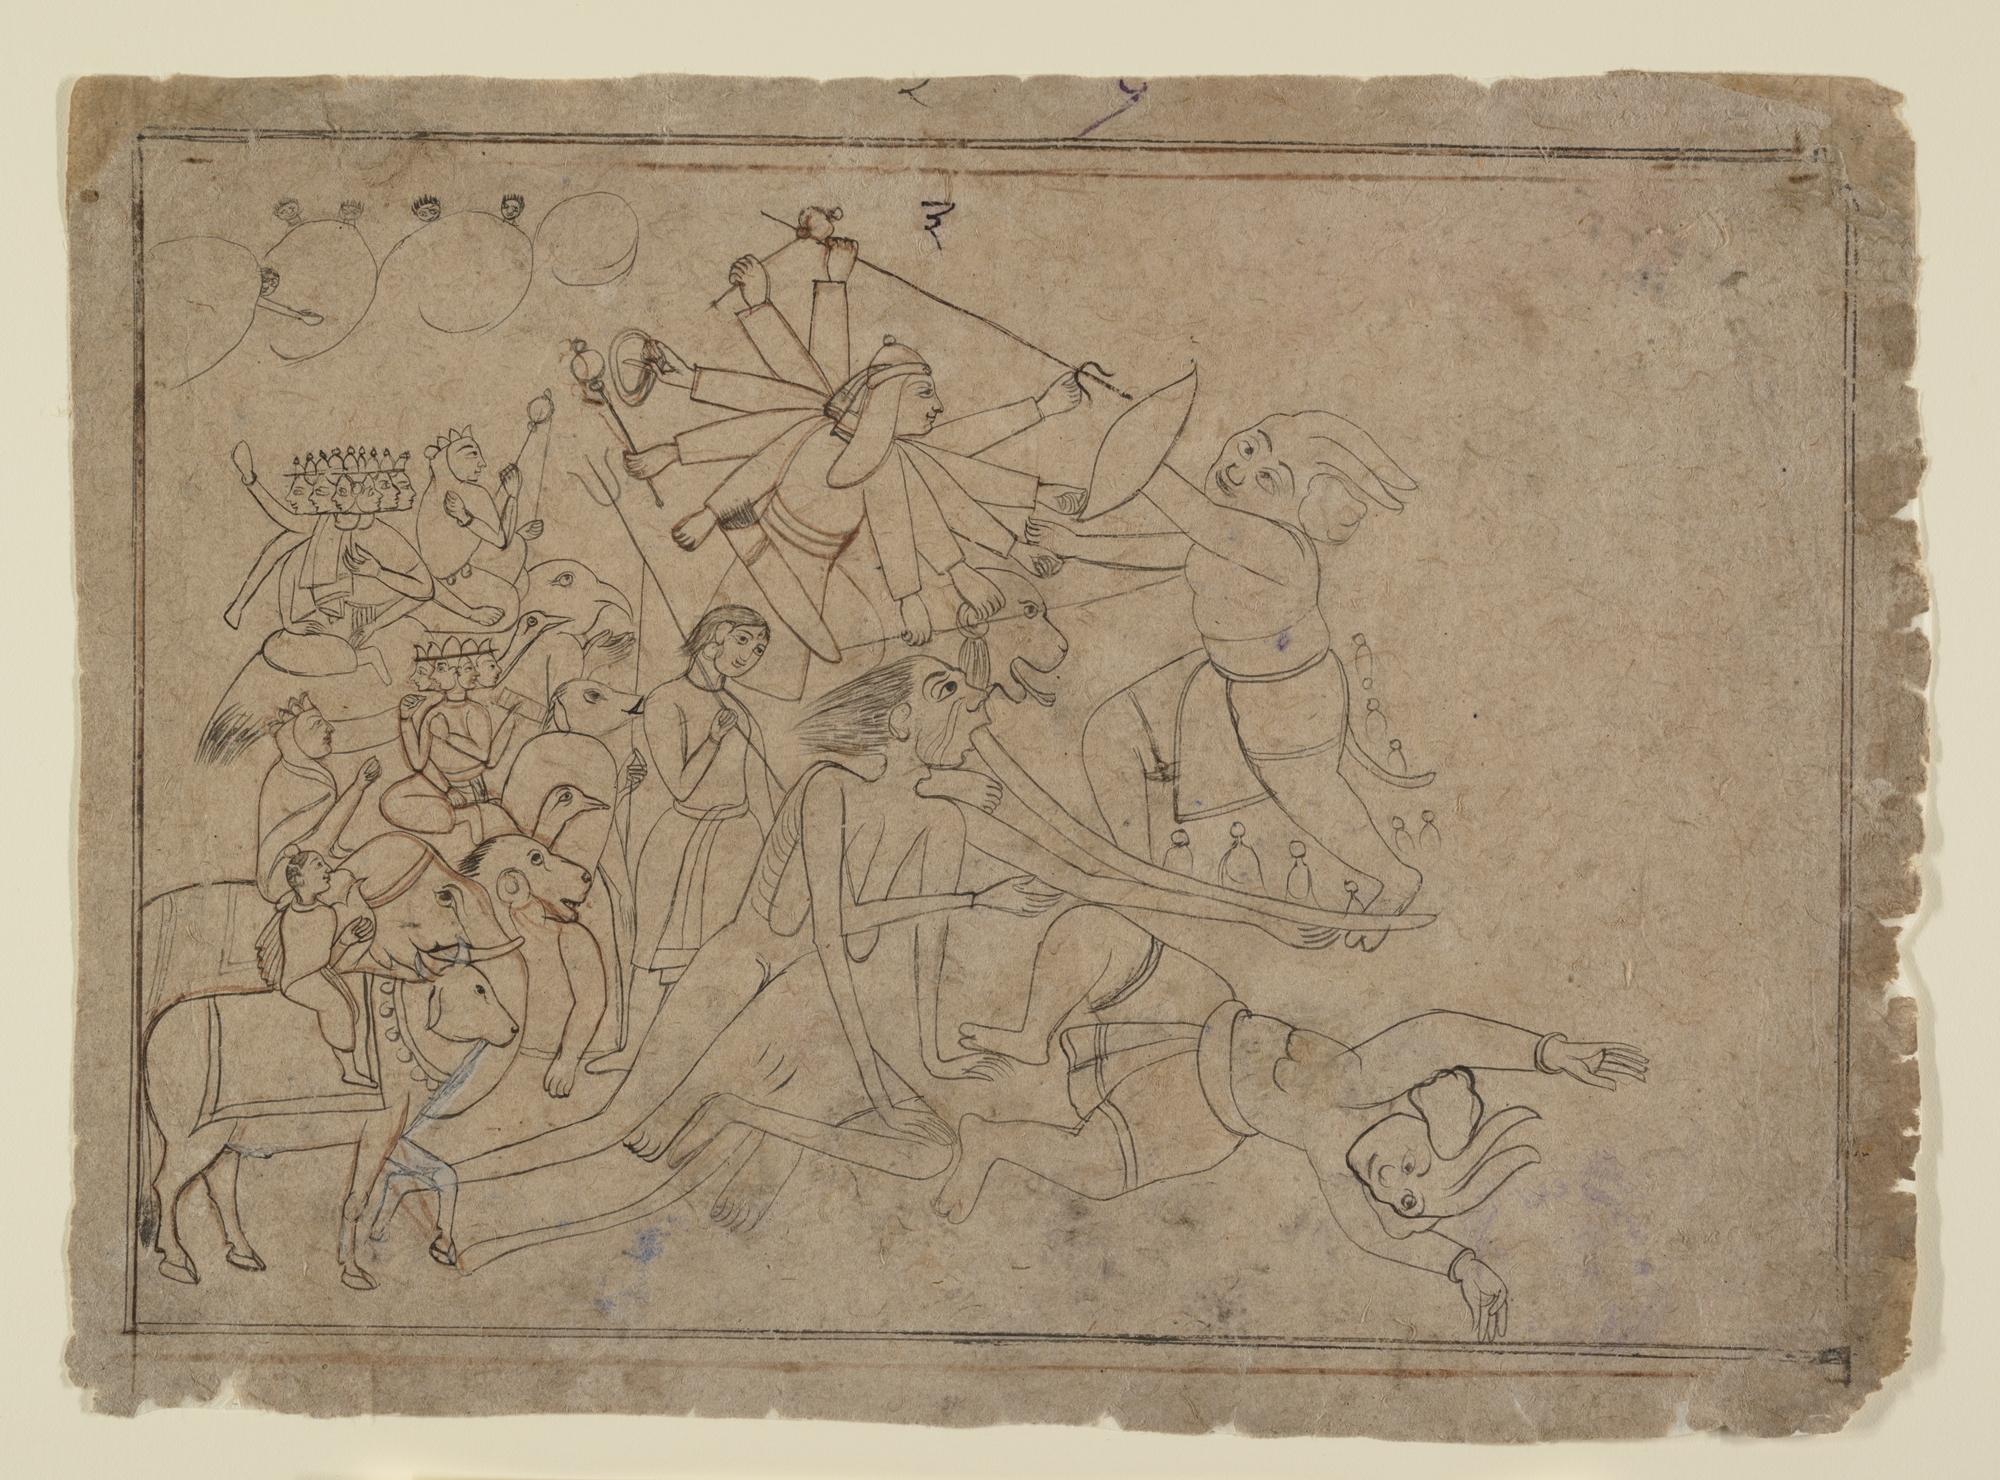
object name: painting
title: Durga, Kali, and the Matrikas Battle the Demon Raktabija: Scene from the Devi Mahatmya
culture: indian, guler, himachal pradesh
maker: nainsukh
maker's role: artist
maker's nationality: indian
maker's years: 1725-1778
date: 1780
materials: ink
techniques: drawing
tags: battles,elephants,demons,durga